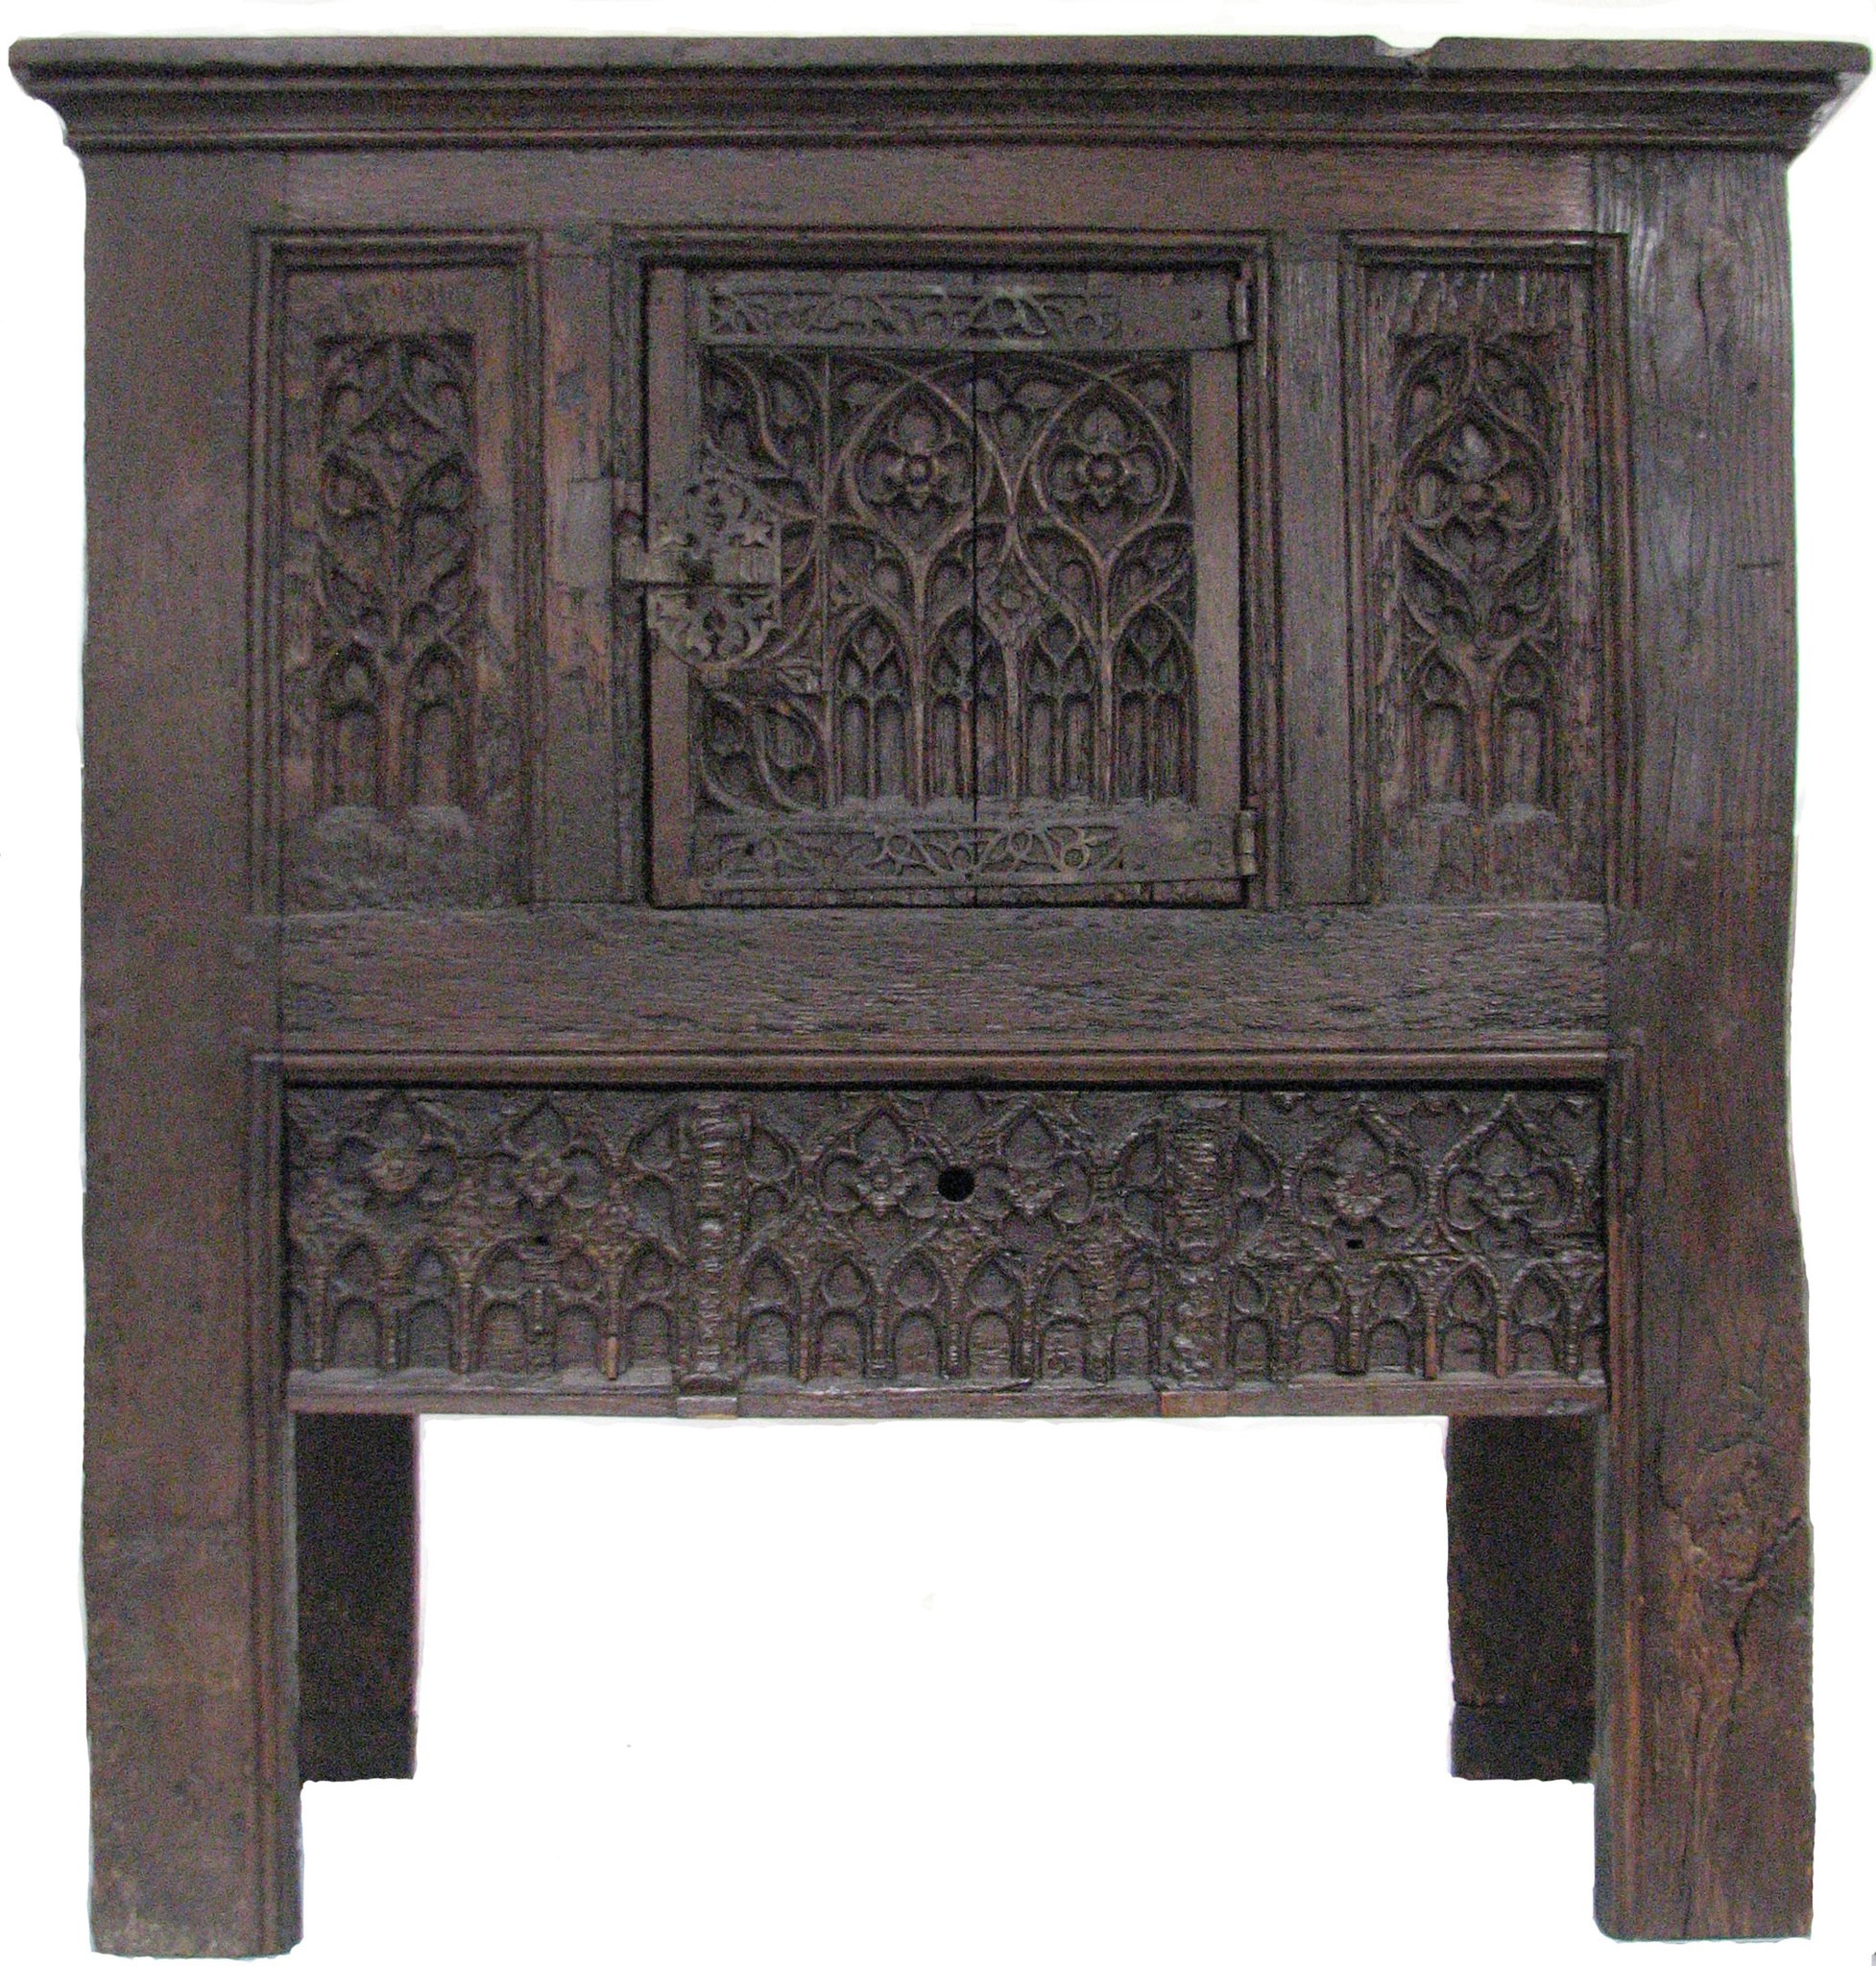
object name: cupboard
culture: french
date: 1460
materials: wood